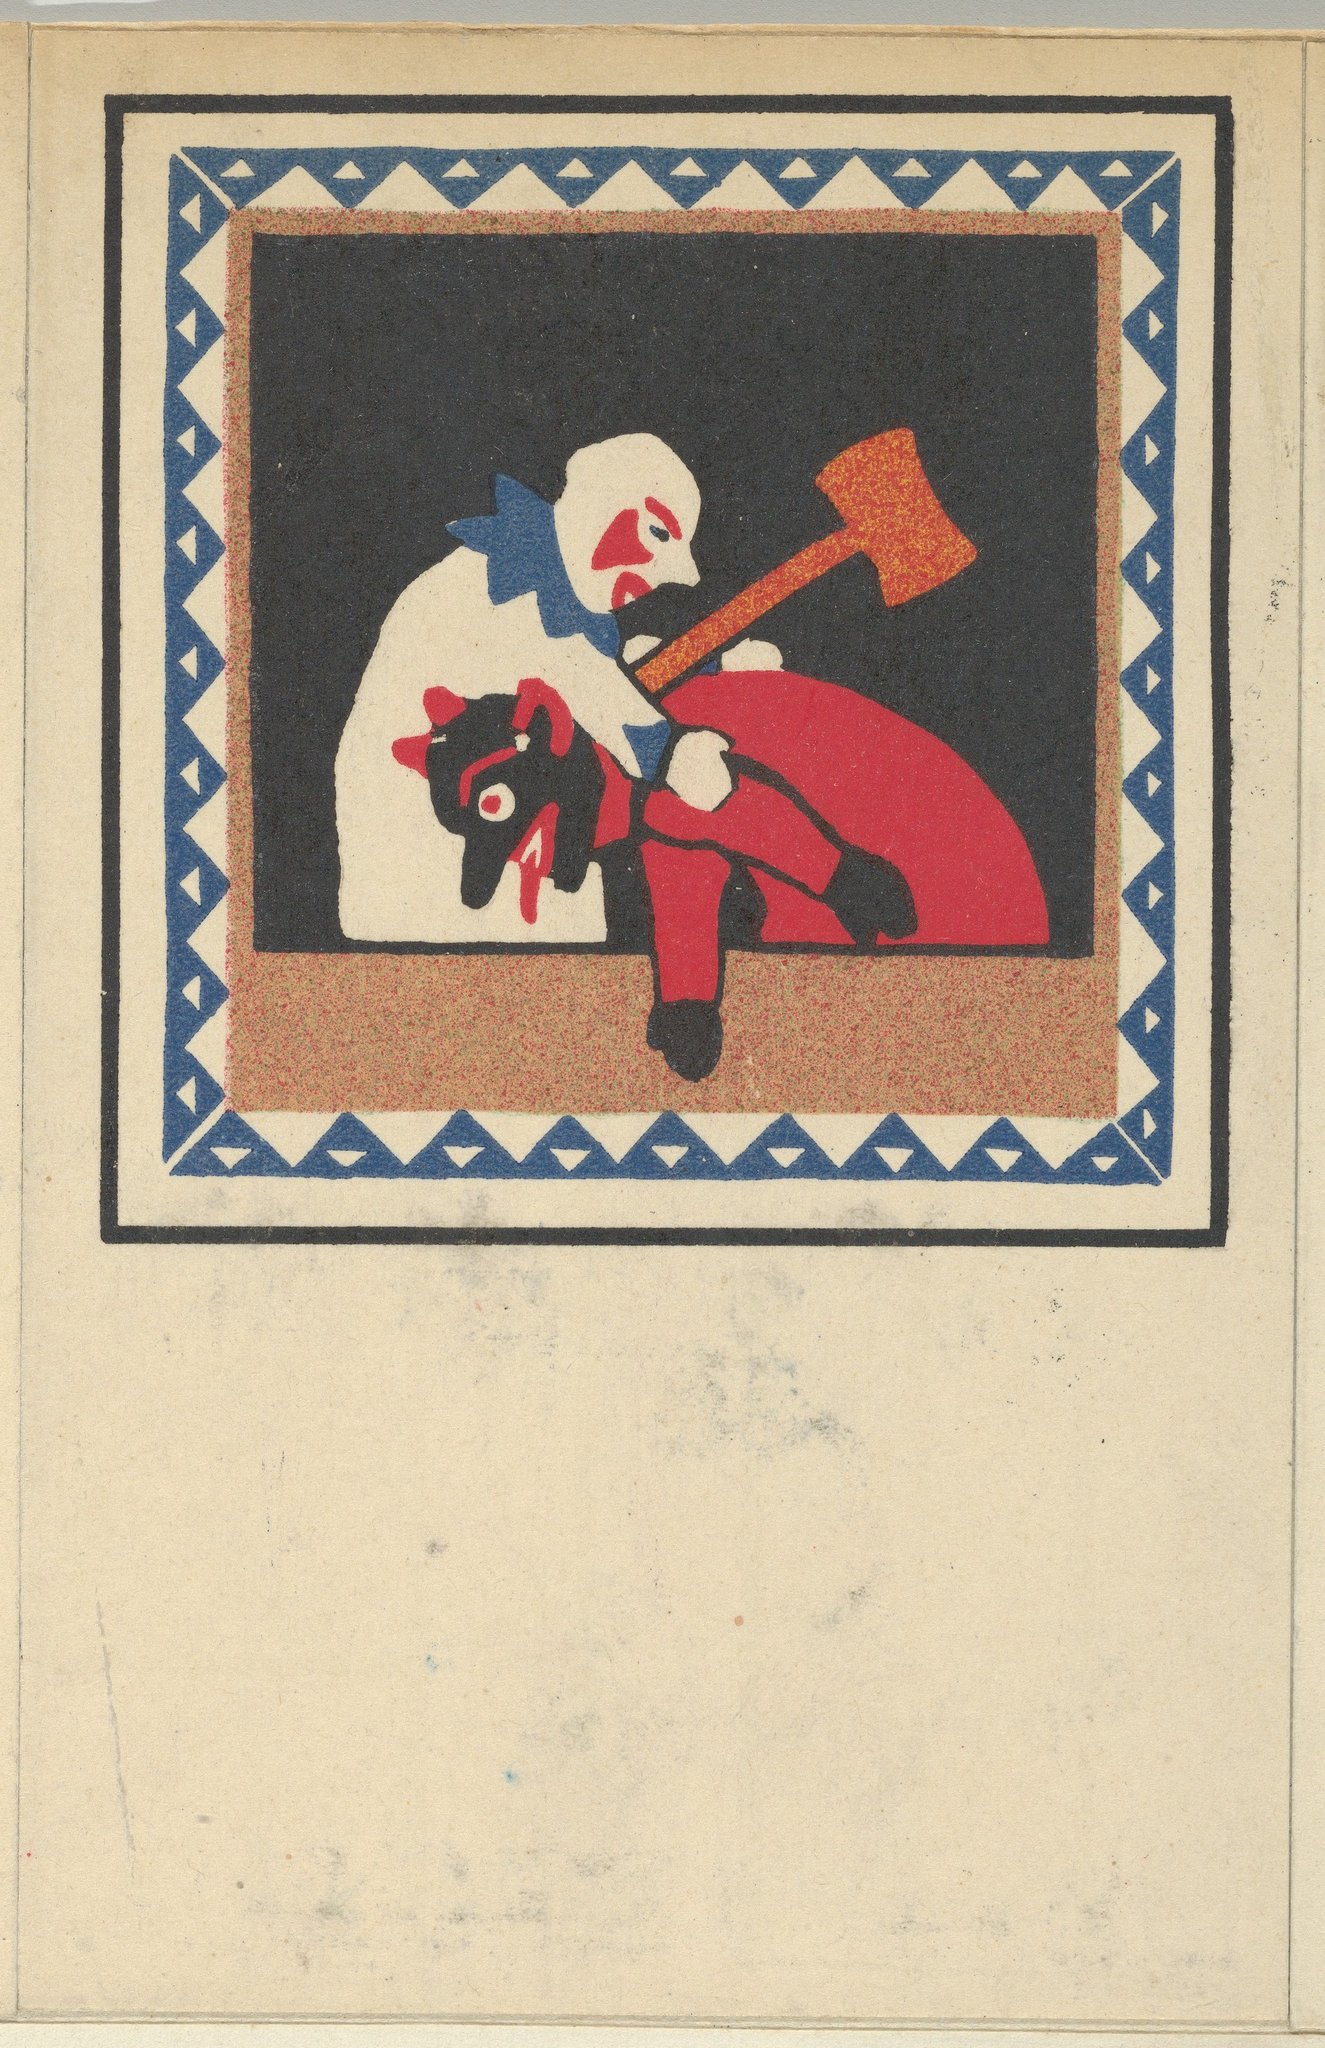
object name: print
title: Kasperl Theater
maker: hans kalmsteiner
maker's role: artist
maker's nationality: austrian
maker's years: 1882-1914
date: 1907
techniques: lithograph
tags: clowns